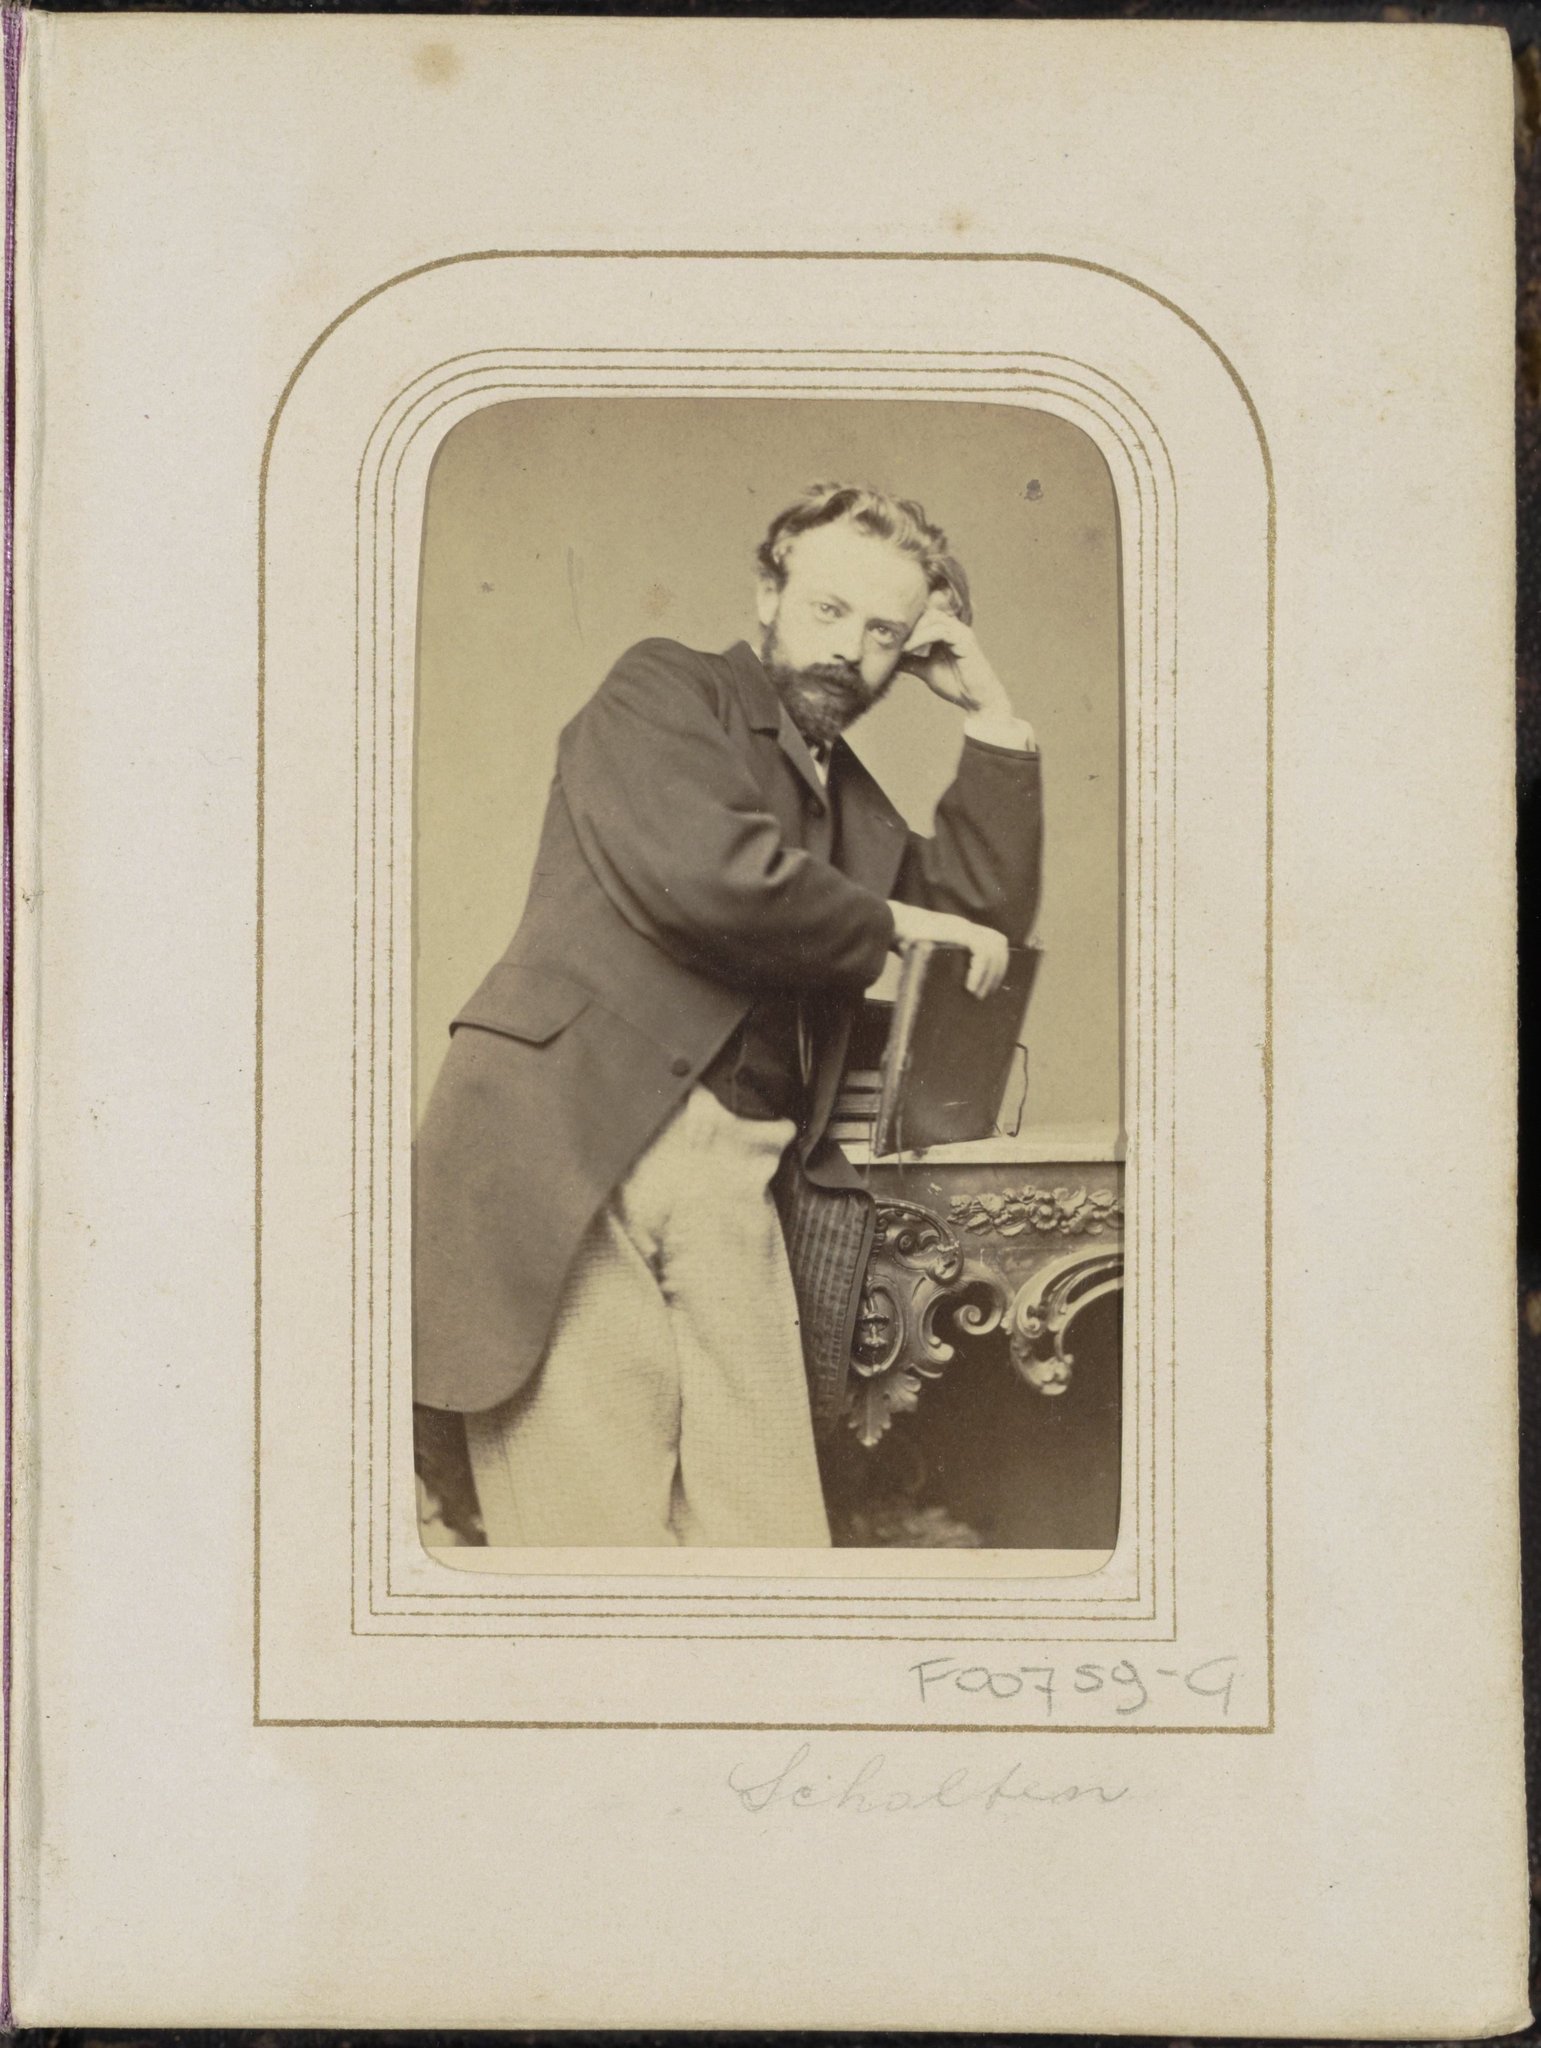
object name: photograph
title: Portret van August Allebé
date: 1860-1875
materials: cardboard, paper, photographic support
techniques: albumen print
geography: amsterdam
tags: amsterdam, print maker, draughtsman, august allebé, studio requisites ~ photographer, historical persons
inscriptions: address: ‘Amsterdam, Spiegelstr. tusschen de Keizersgr. en Kerkstr. C 686’, inscription: ‘Scholten’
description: Onderdeel van Fotoalbum van een Nederlandse familie met 50 cartes-de-visite.